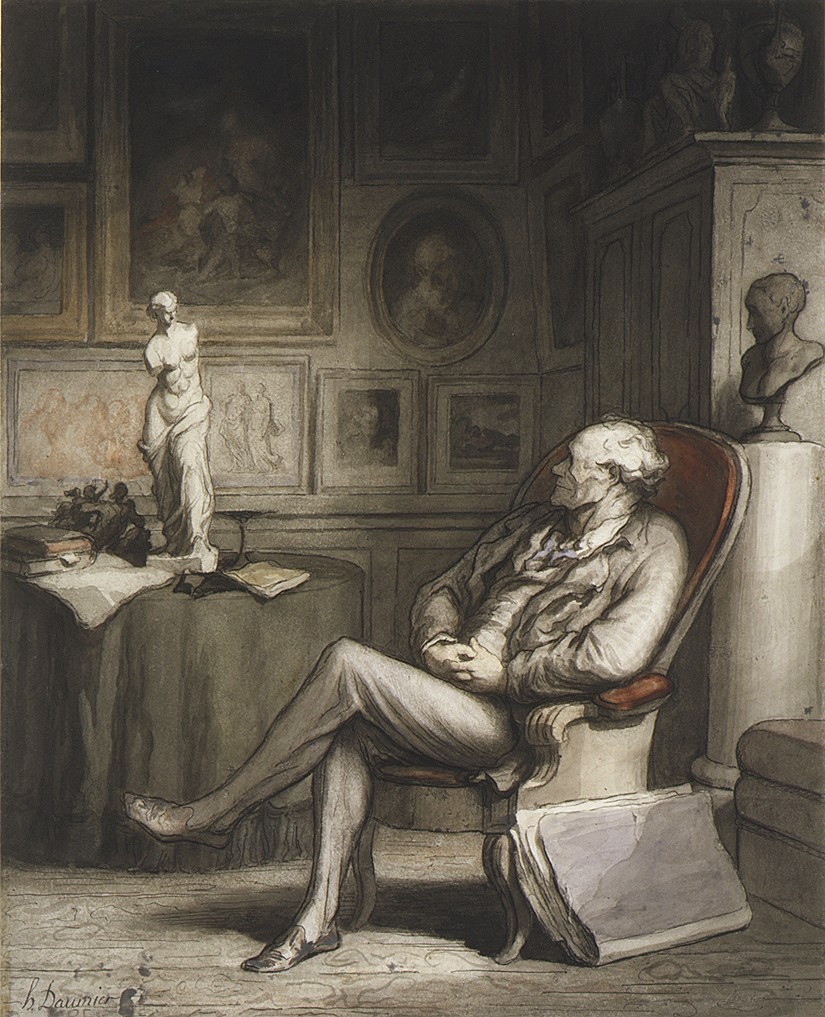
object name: drawing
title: The Connoisseur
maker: honoré daumier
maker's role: artist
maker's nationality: french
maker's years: 1808-1879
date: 1860-1865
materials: chalk, crayon, gouache, ink, watercolor, paper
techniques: lithograph, pen, wash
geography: france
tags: sculpture,interiors,contemplation,men